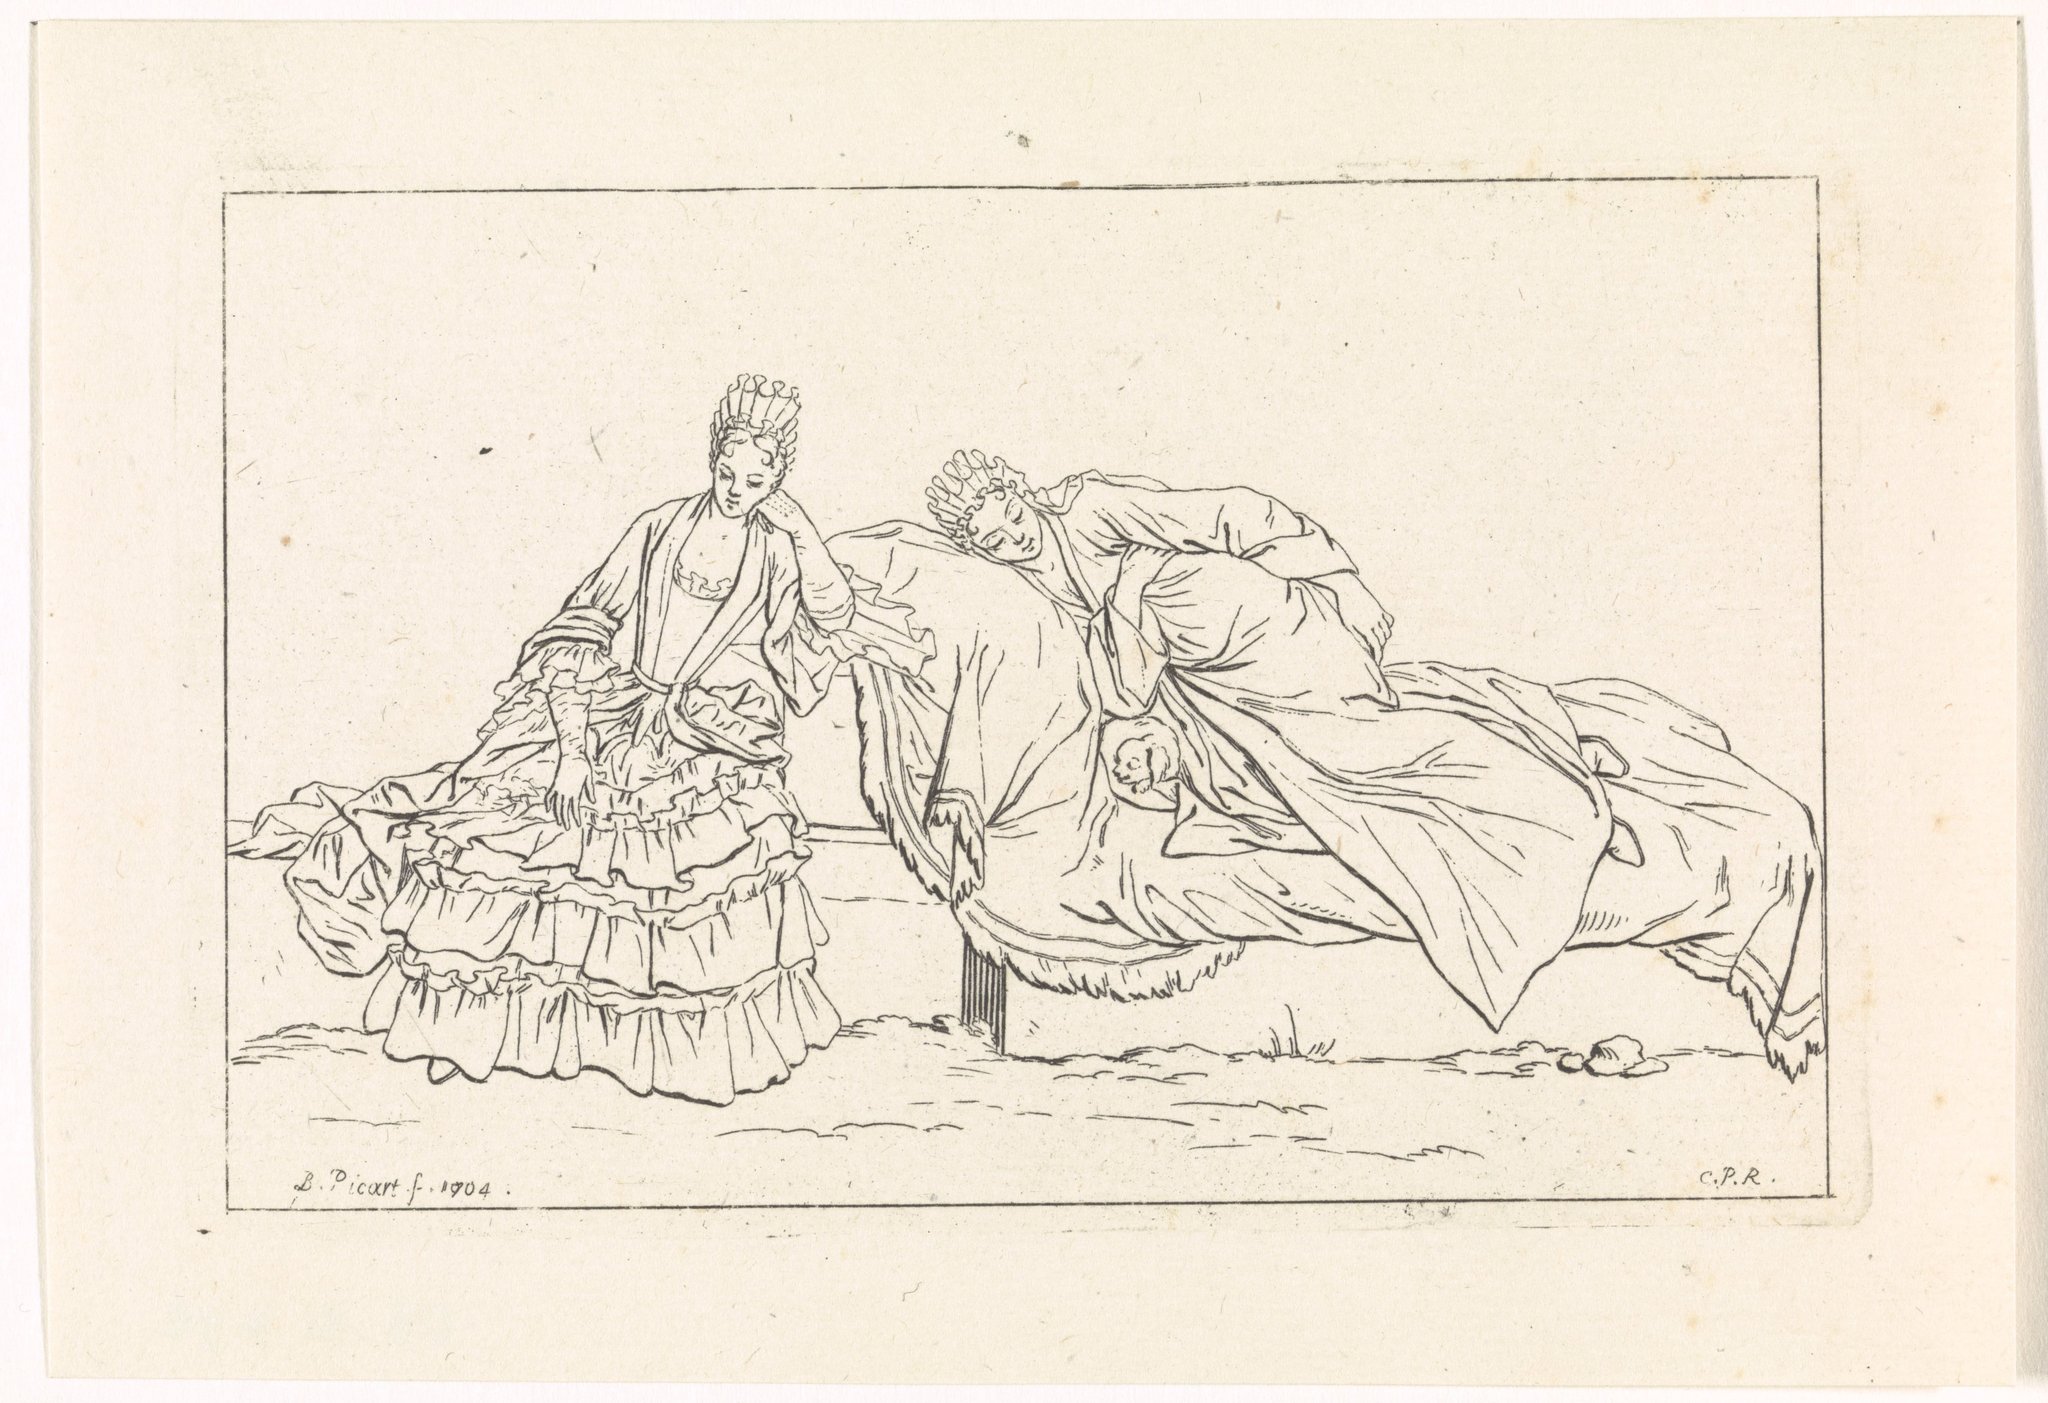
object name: print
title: Studiebladen met modeverschijnselen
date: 1704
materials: paper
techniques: etching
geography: paris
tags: sleeping; unconsciousness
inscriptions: date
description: Een vrouw rust op een ligbed met haar hondje. De ander leunt er tegen aan. Ze dragen eigentijdse kleding.